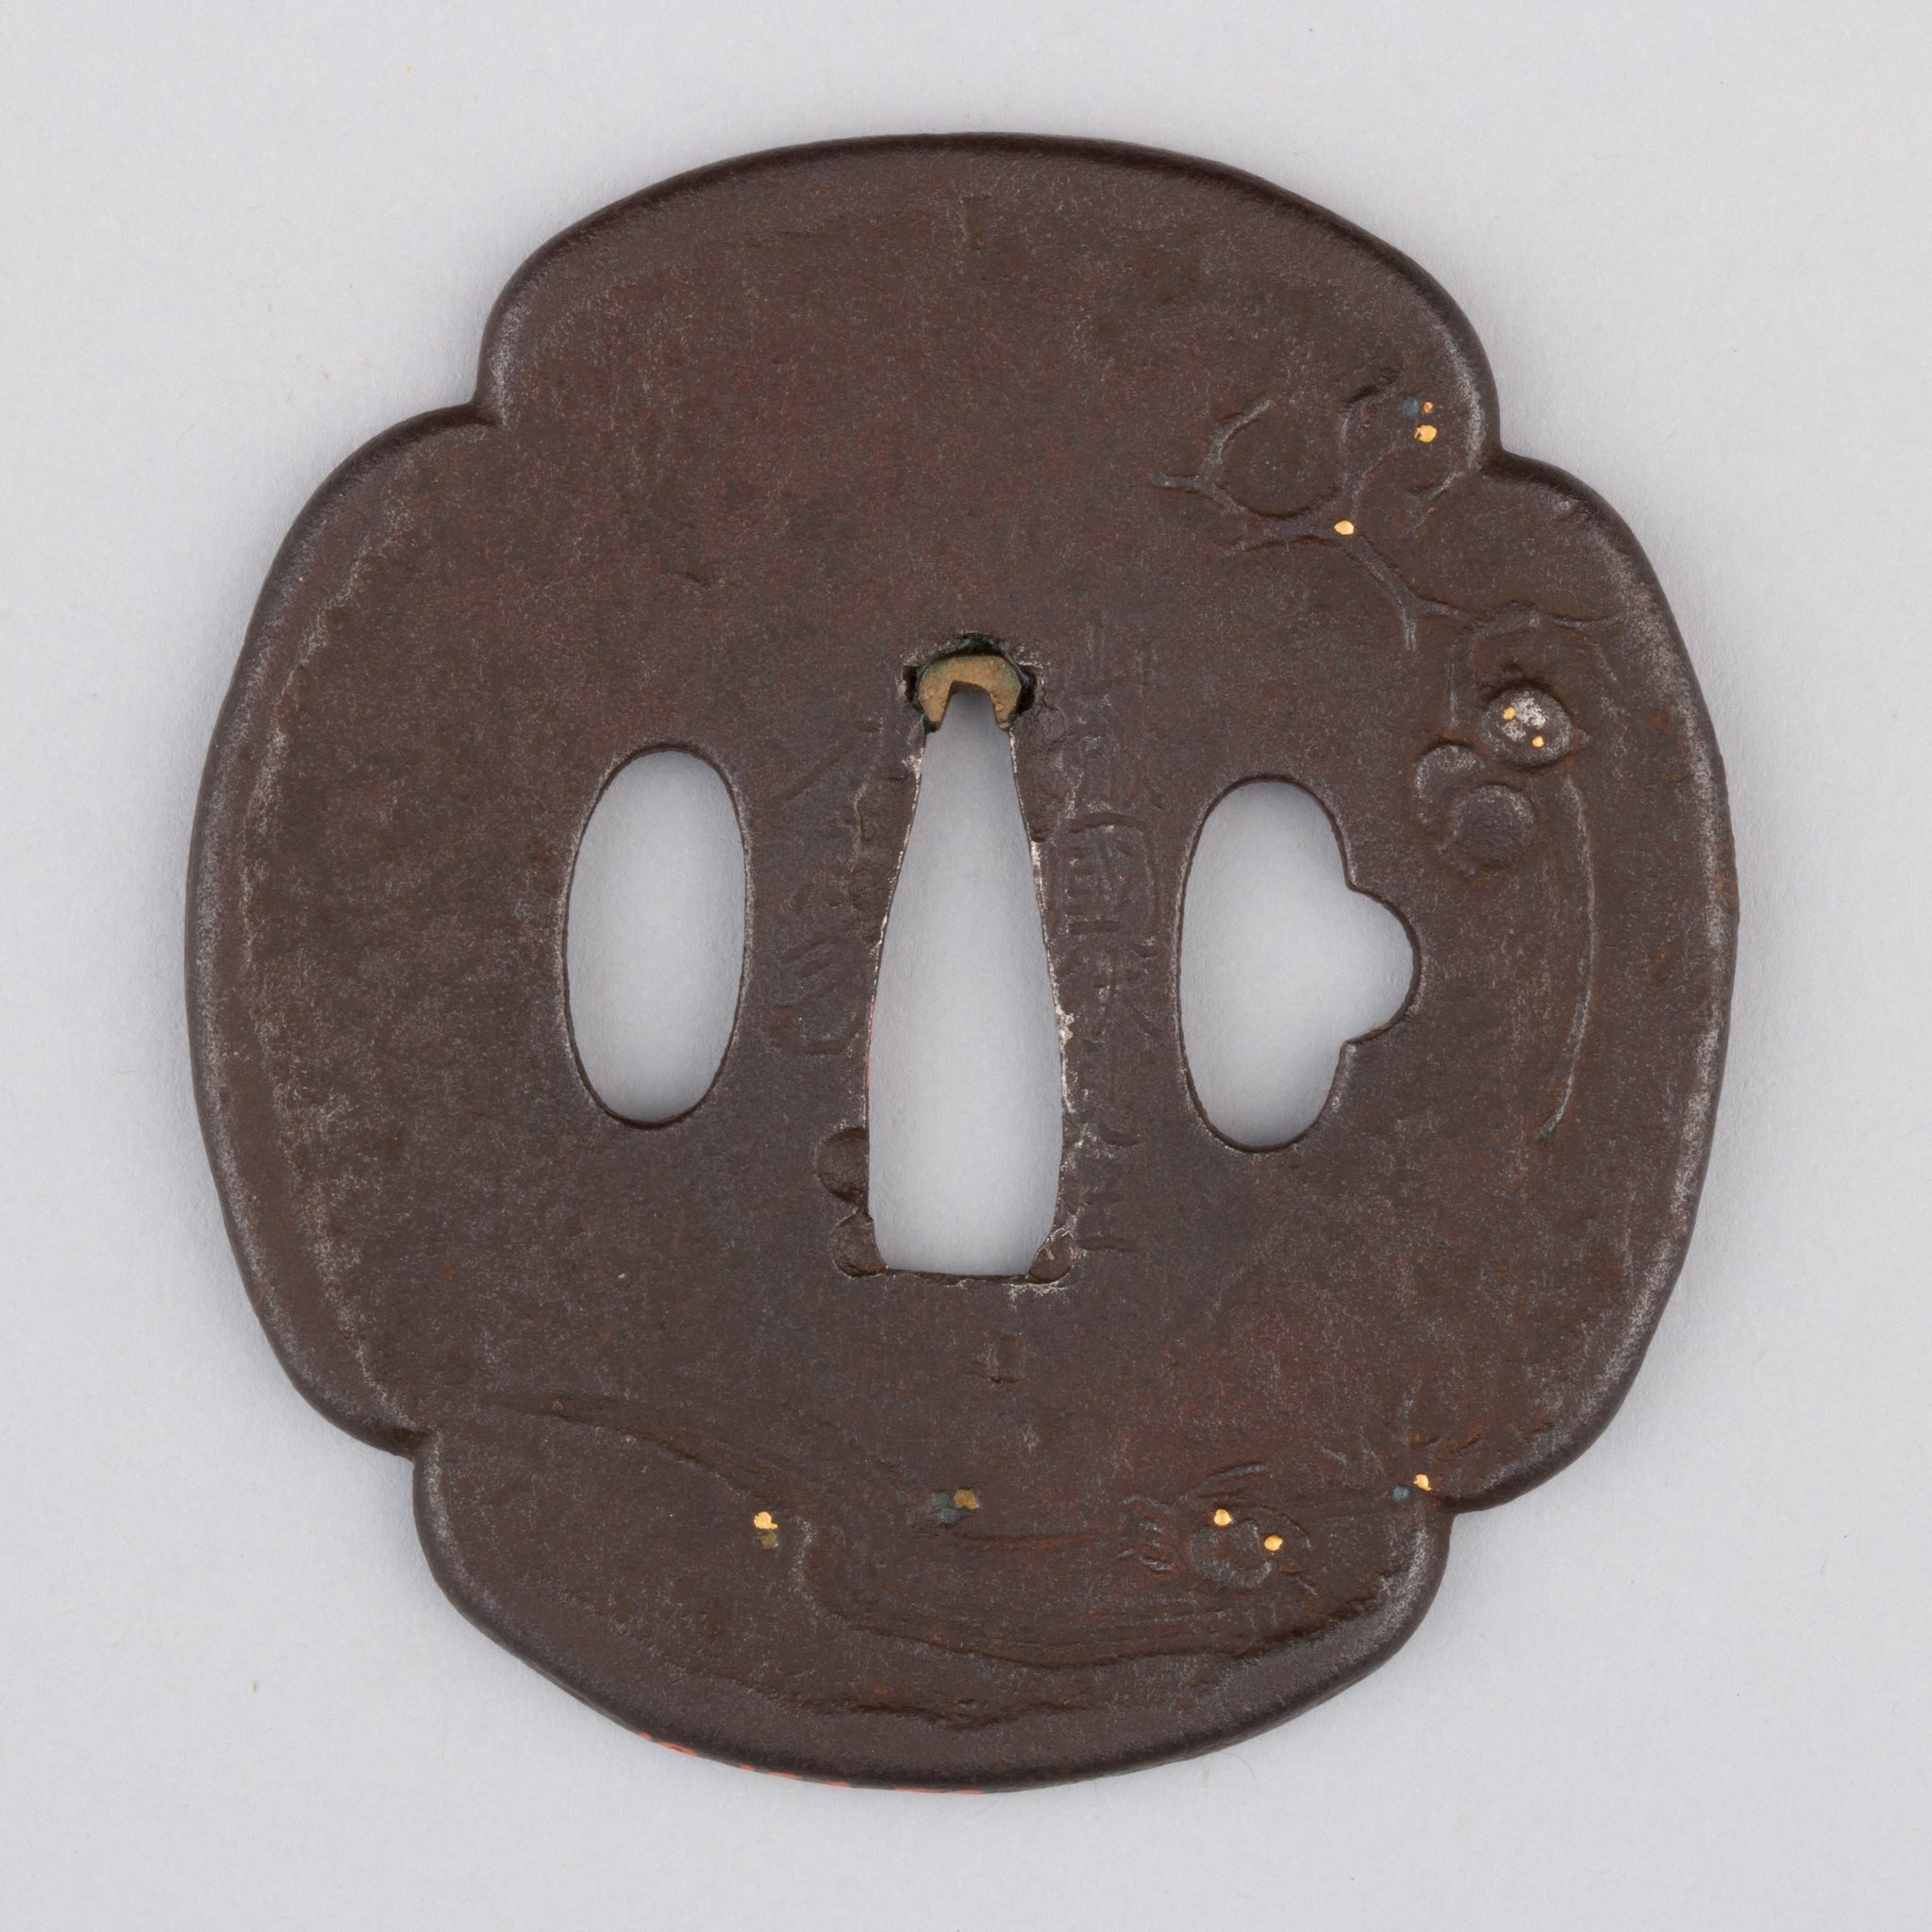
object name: sword guard tsuba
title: Sword Guard (Tsuba)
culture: japanese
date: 1615-1868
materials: copper, iron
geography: japan